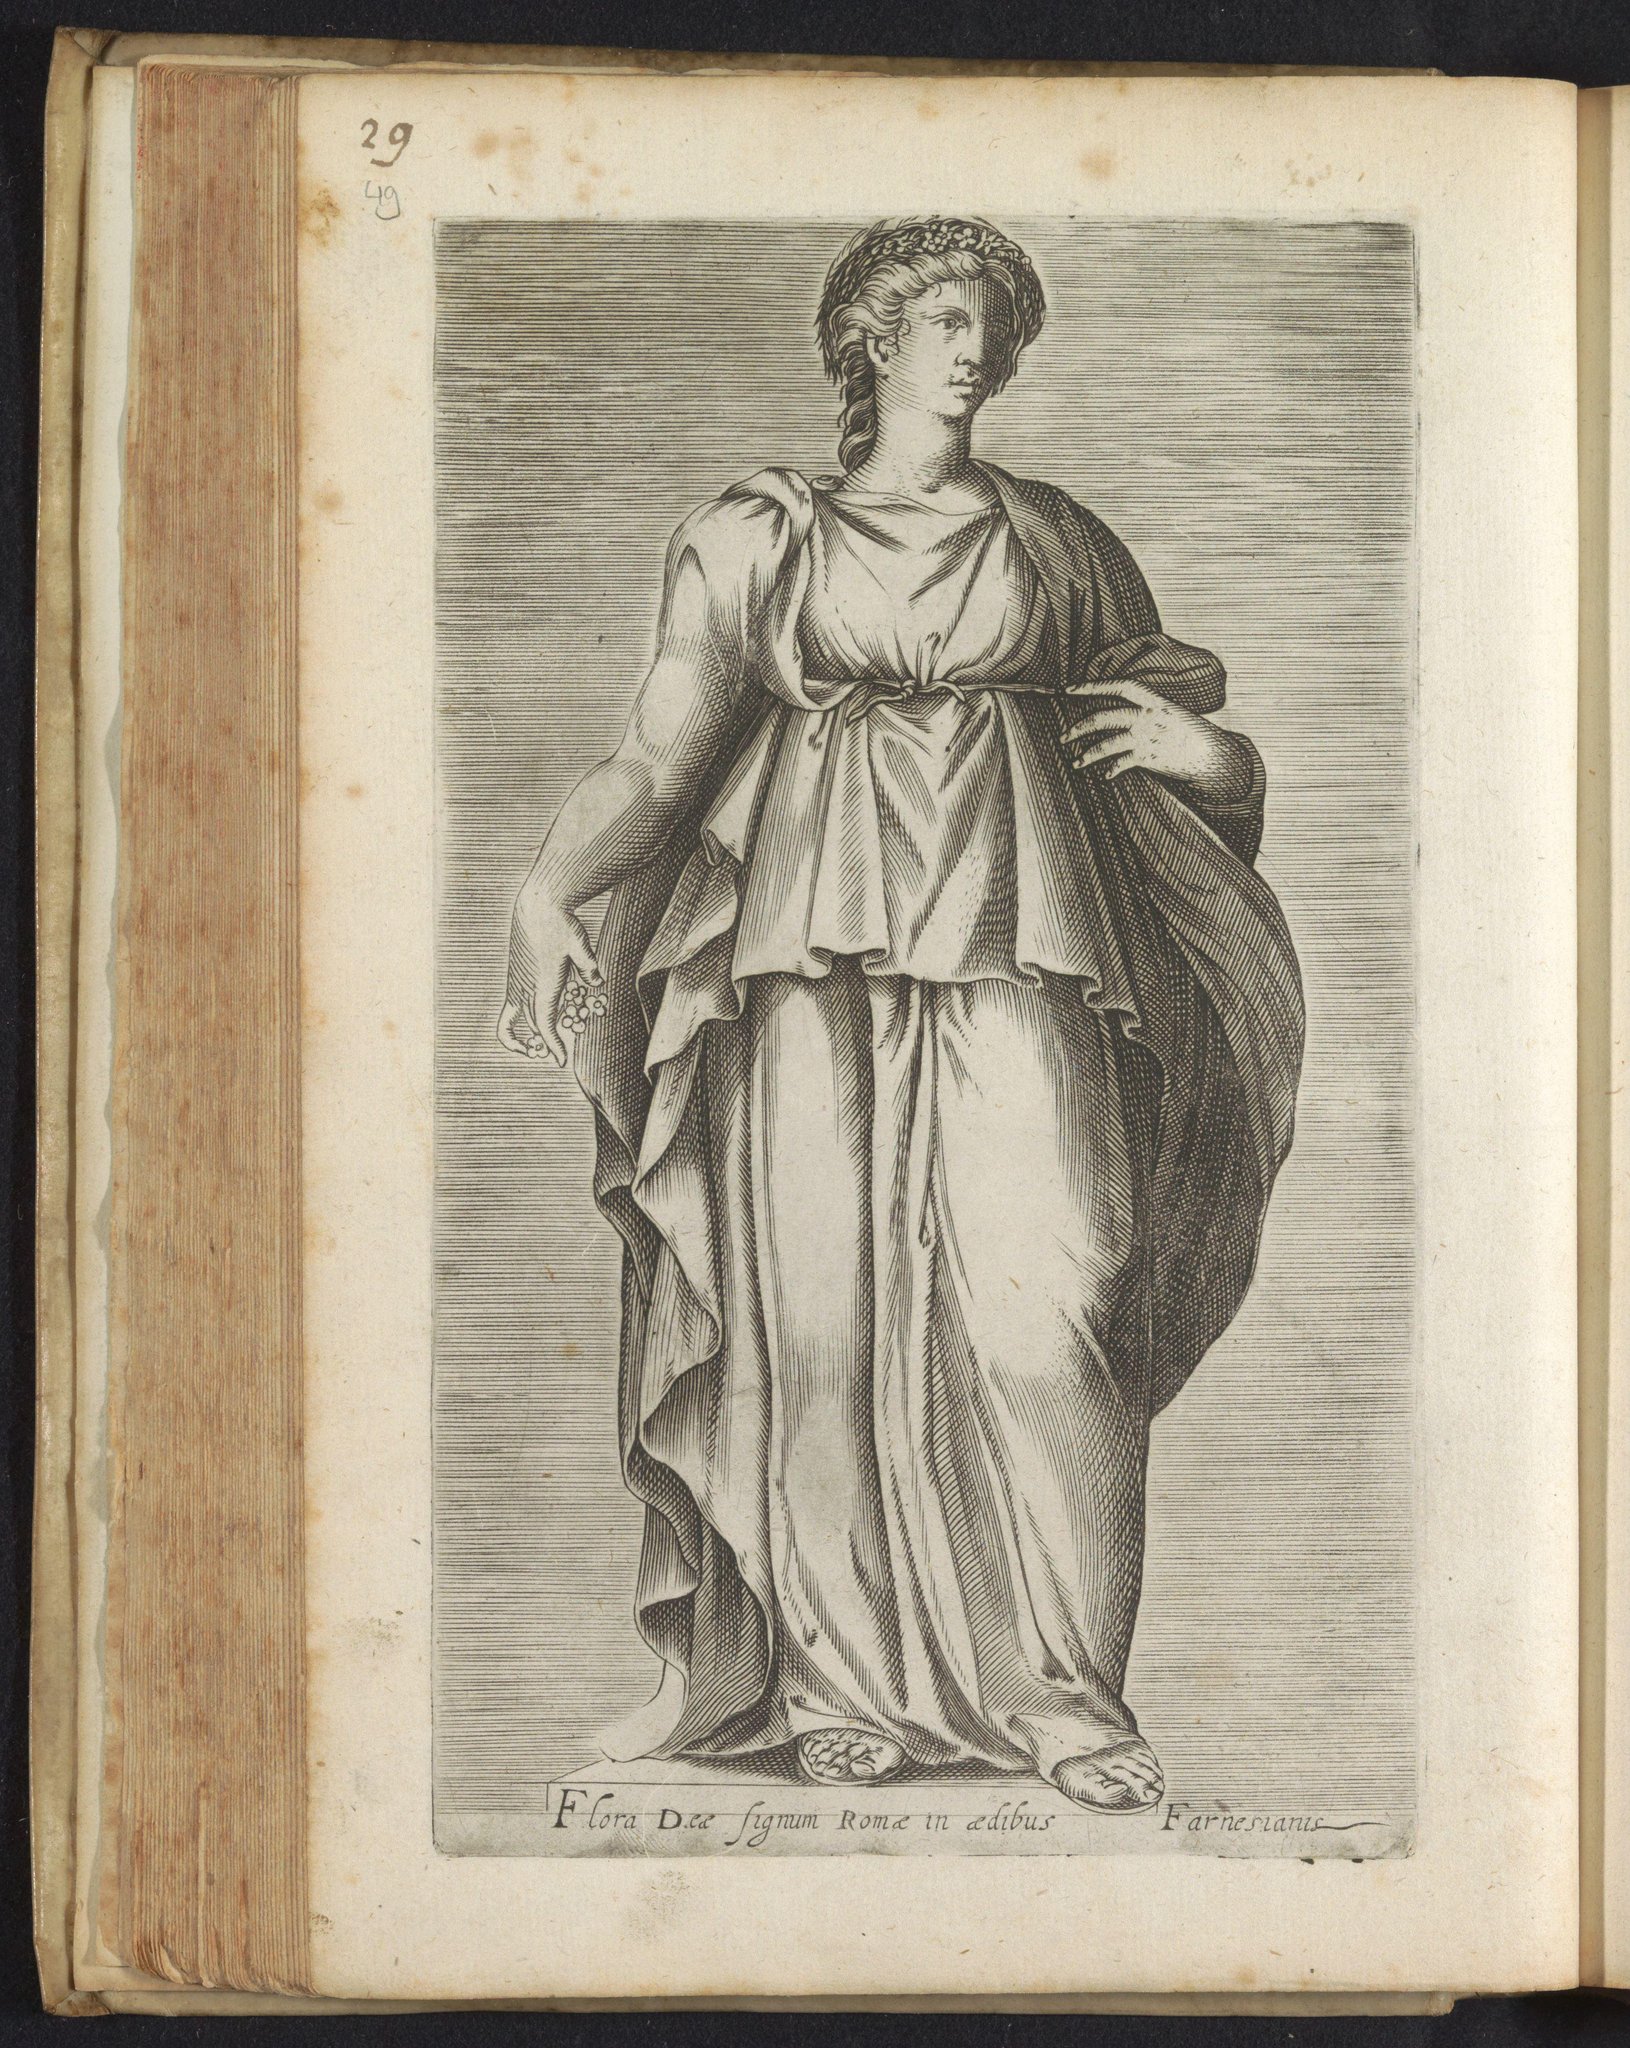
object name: album leaf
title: Flora deae signum Romae in aedibus Farnesianis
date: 1584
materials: paper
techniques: engraving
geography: italy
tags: piece of sculpture, reproduction of a piece of sculpture, (story of) flora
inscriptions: number: ‘29’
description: Deze prent maakt deel uit van een set van 79 prenten (+ titelprent) met voorstellingen van antieke sculpturen in Rome.